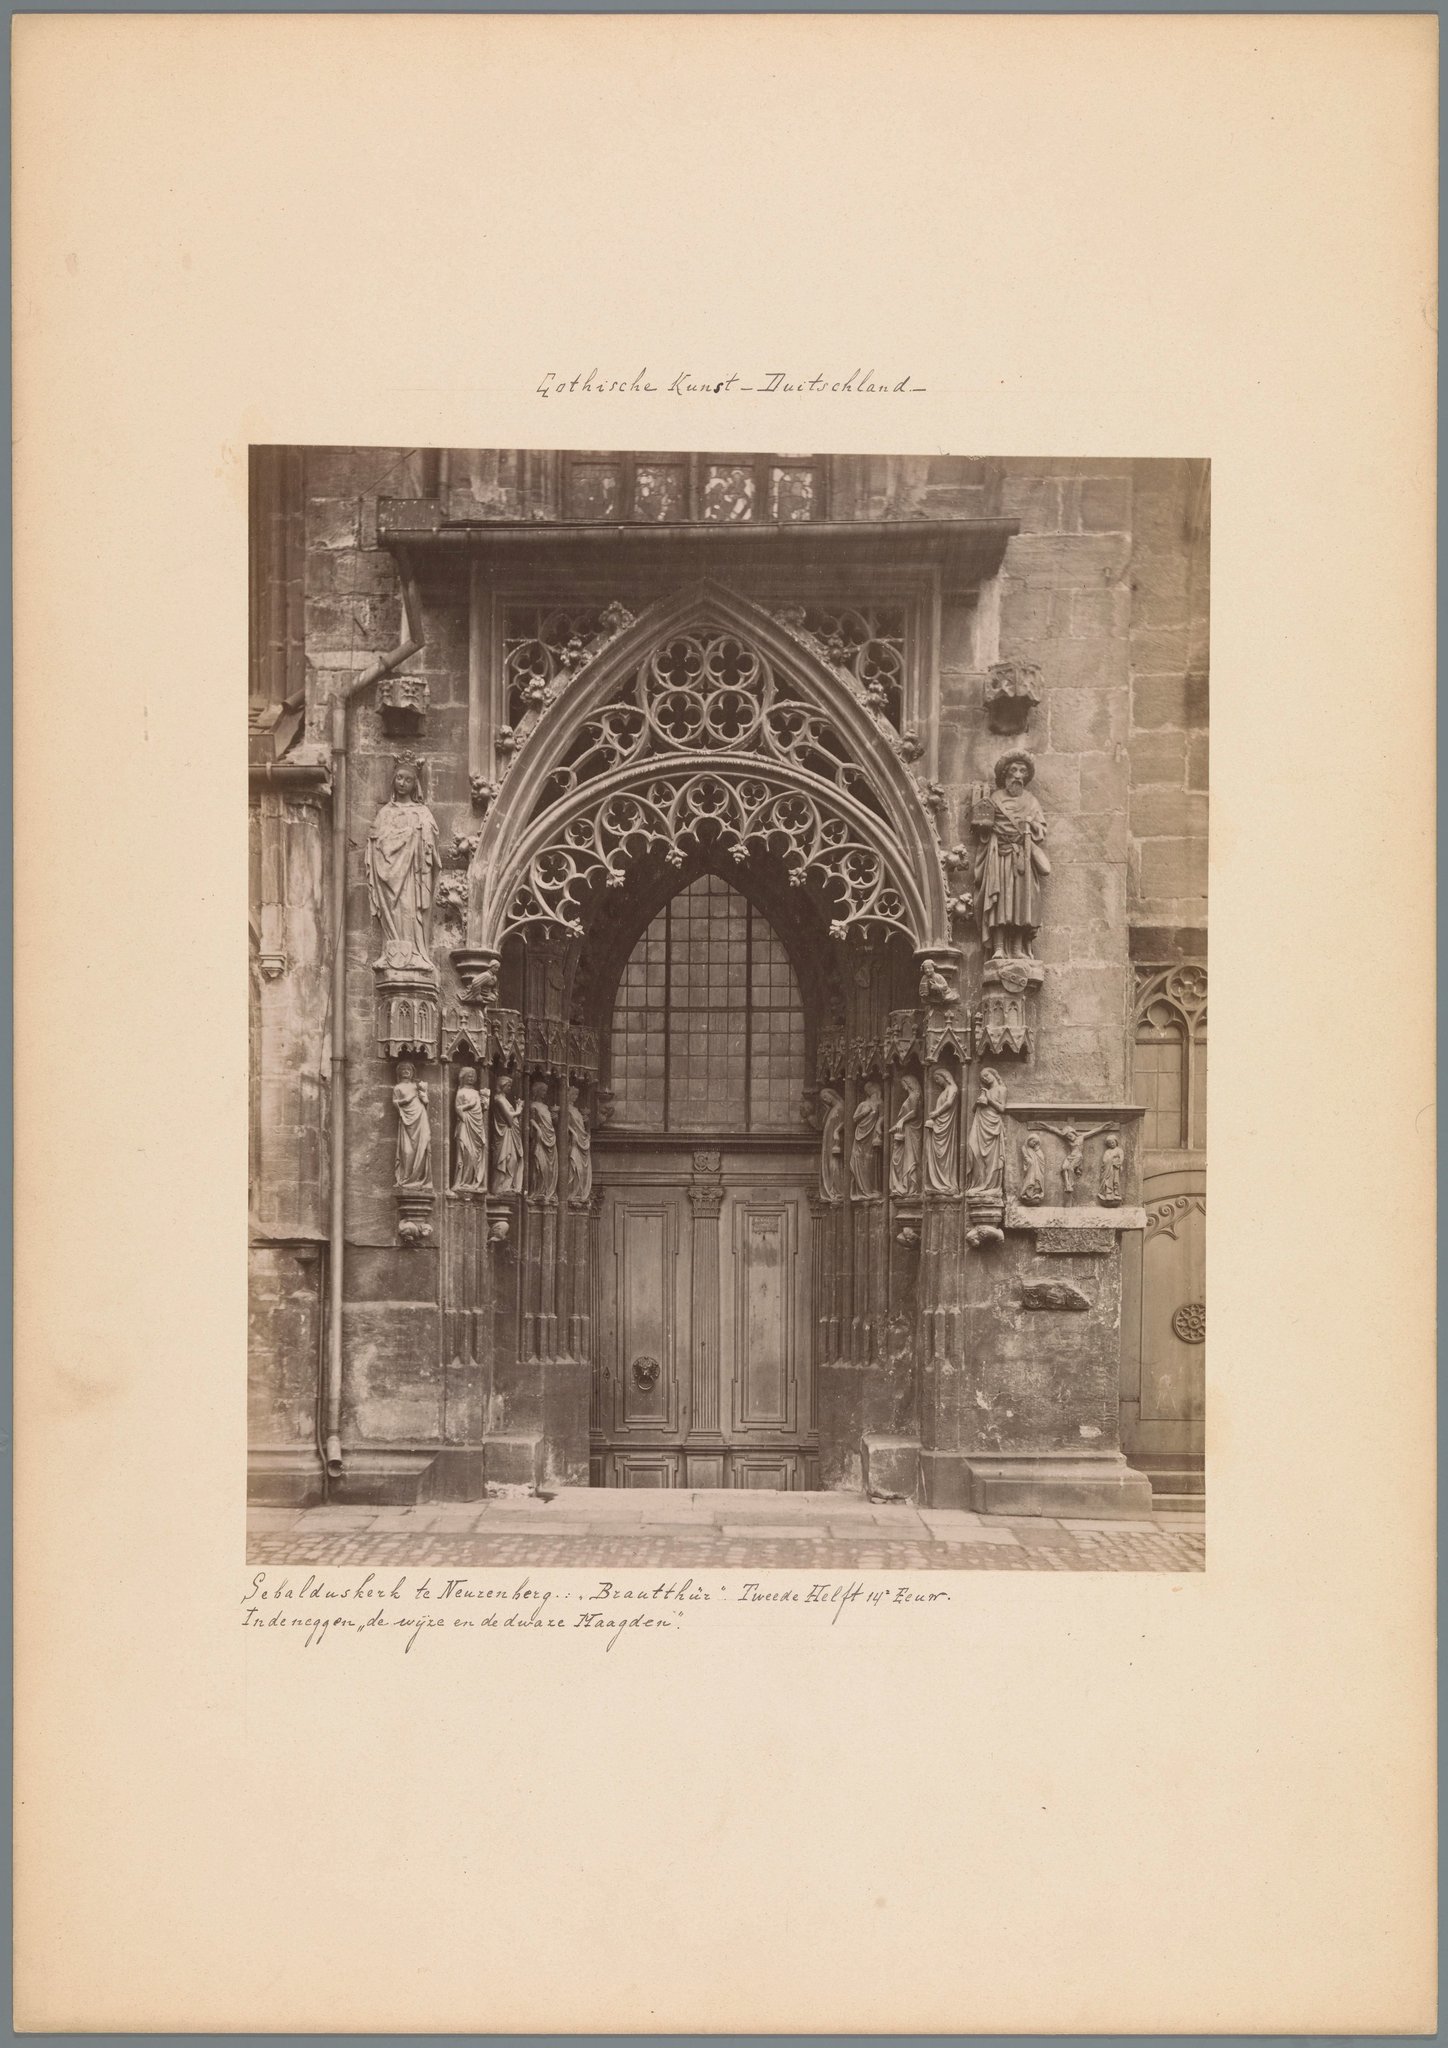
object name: photograph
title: Sebalduskerk te Neurenberg. : ,,Brauthür".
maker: Anonymous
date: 1875-1900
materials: cardboard, photographic support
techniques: albumen print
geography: nuremberg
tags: parts of church exterior and annexes: portal, sculpture (+ relief ~ sculpture)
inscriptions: inscription: ‘Gothische Kunst - Duitschland.’, collector's mark: ‘KUNSTNIJVERHEIDSCHOOL QUELLINUS AMSTERDAM FRANS HALSSTRAAT 14.’, collector's mark: ‘INSTITUUT VOOR KUNST-NIJVERHEIDSONDERWIJS GABRIËL METSUSTRAAT No. 16 AMSTERDAM’